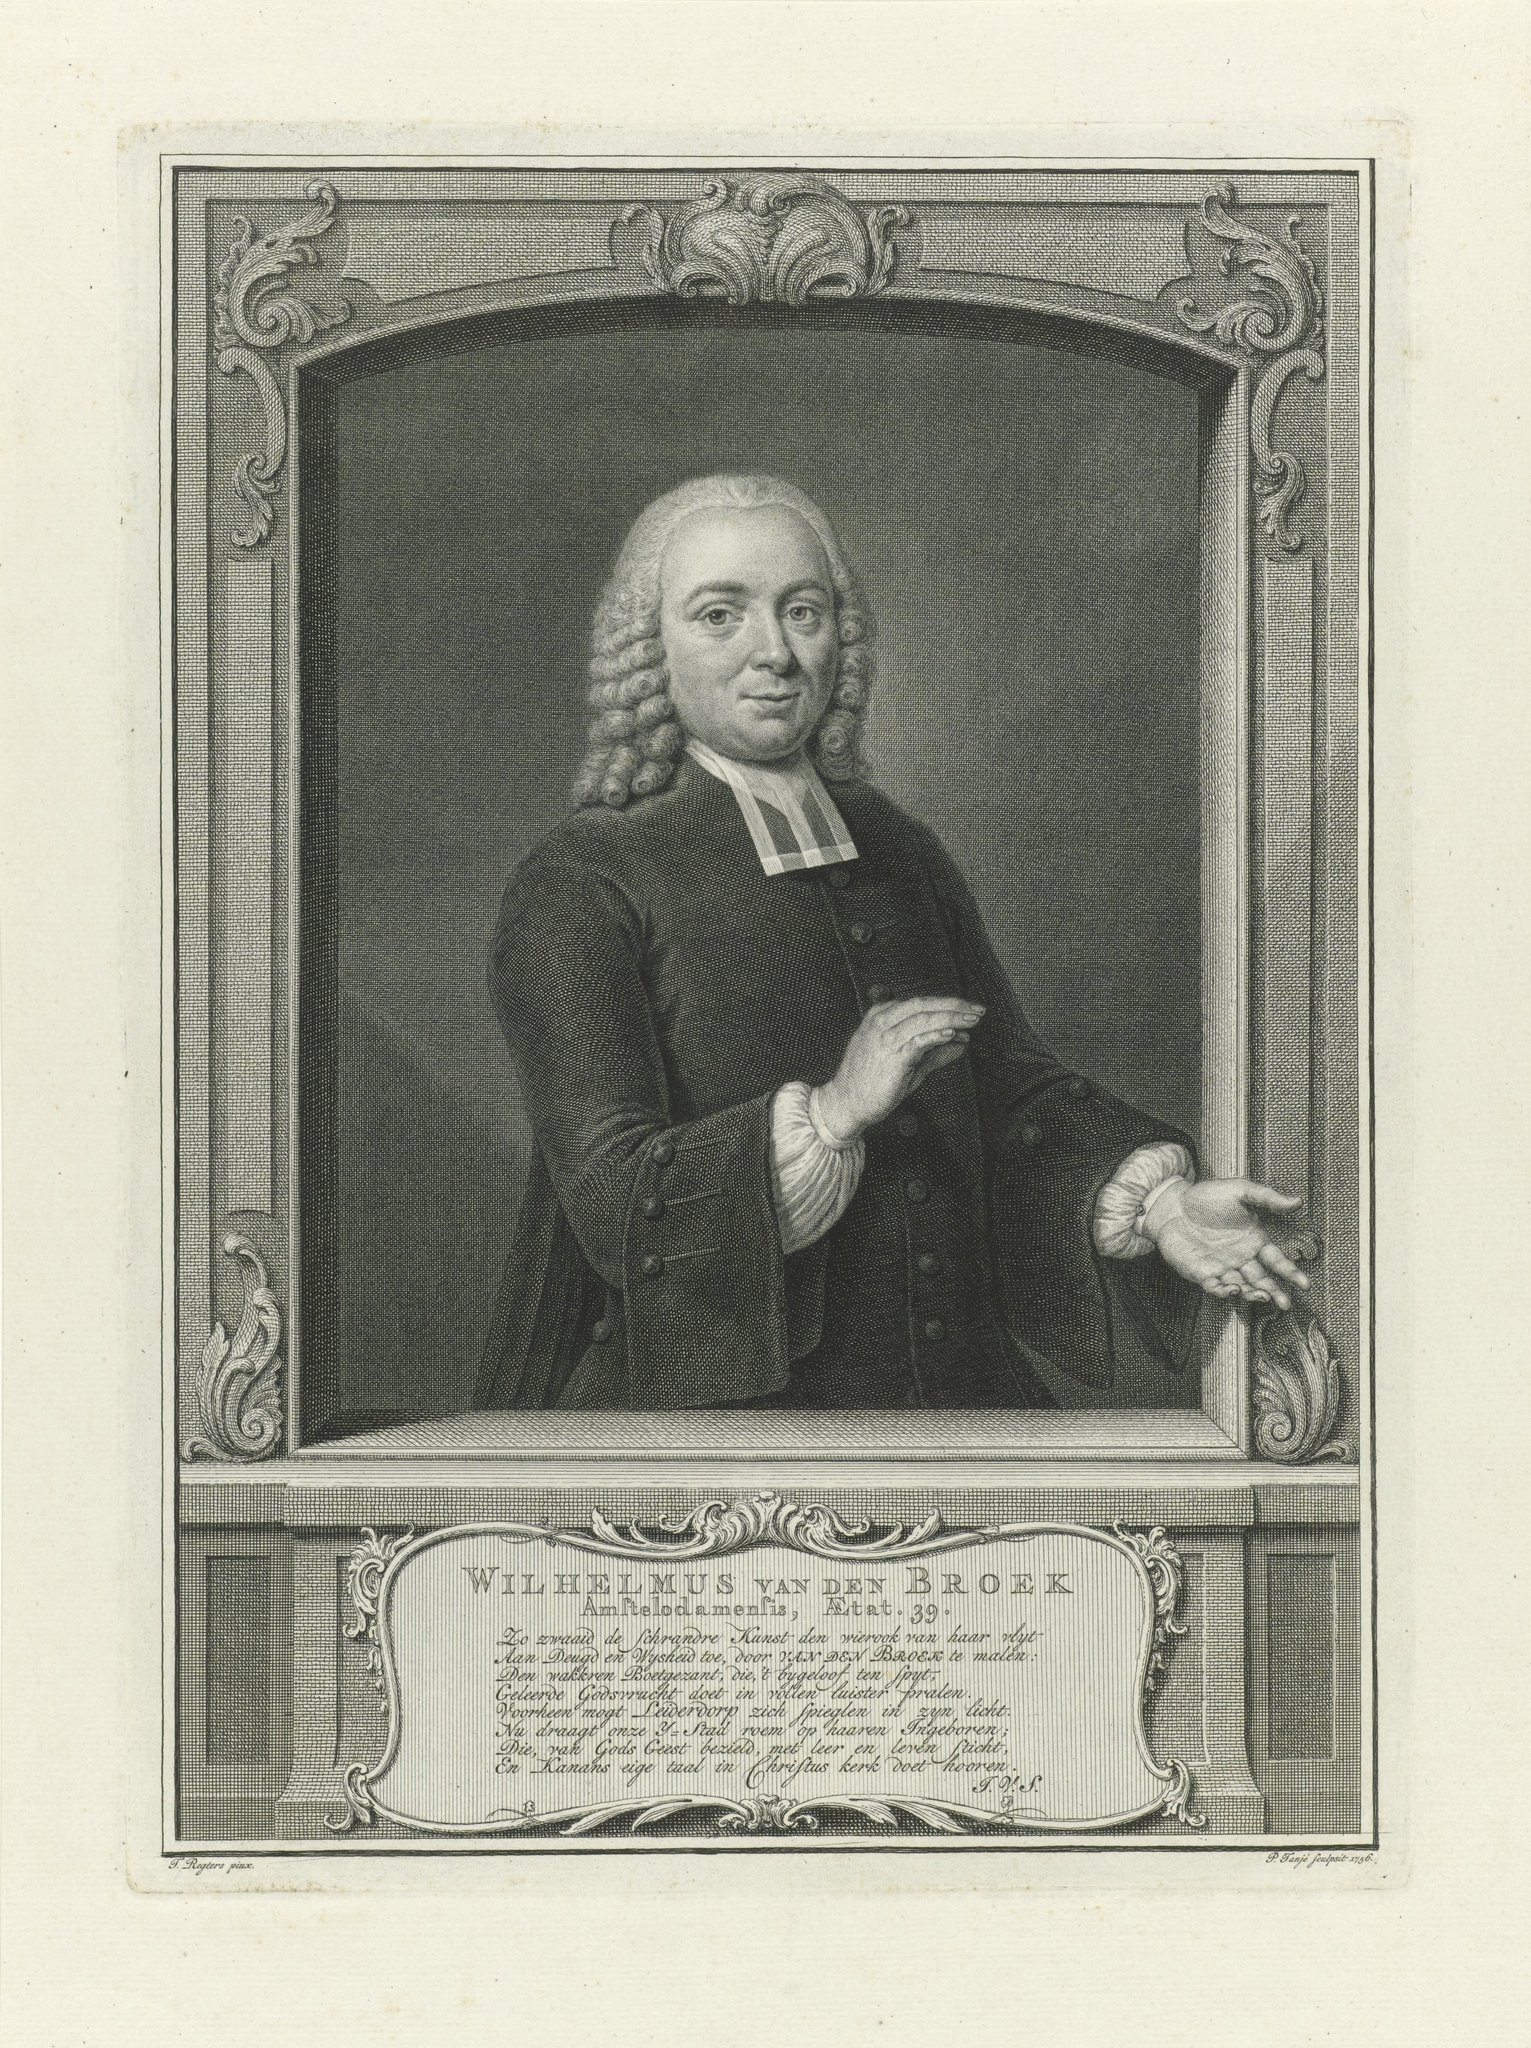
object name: print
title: Portret van Willem van den Broek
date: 1756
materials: paper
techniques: engraving, etching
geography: amsterdam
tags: amsterdam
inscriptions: collector's mark: Lugt 240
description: Portret van Willem van den Broek, predikant te Amsterdam, op 39-jarige leeftijd.